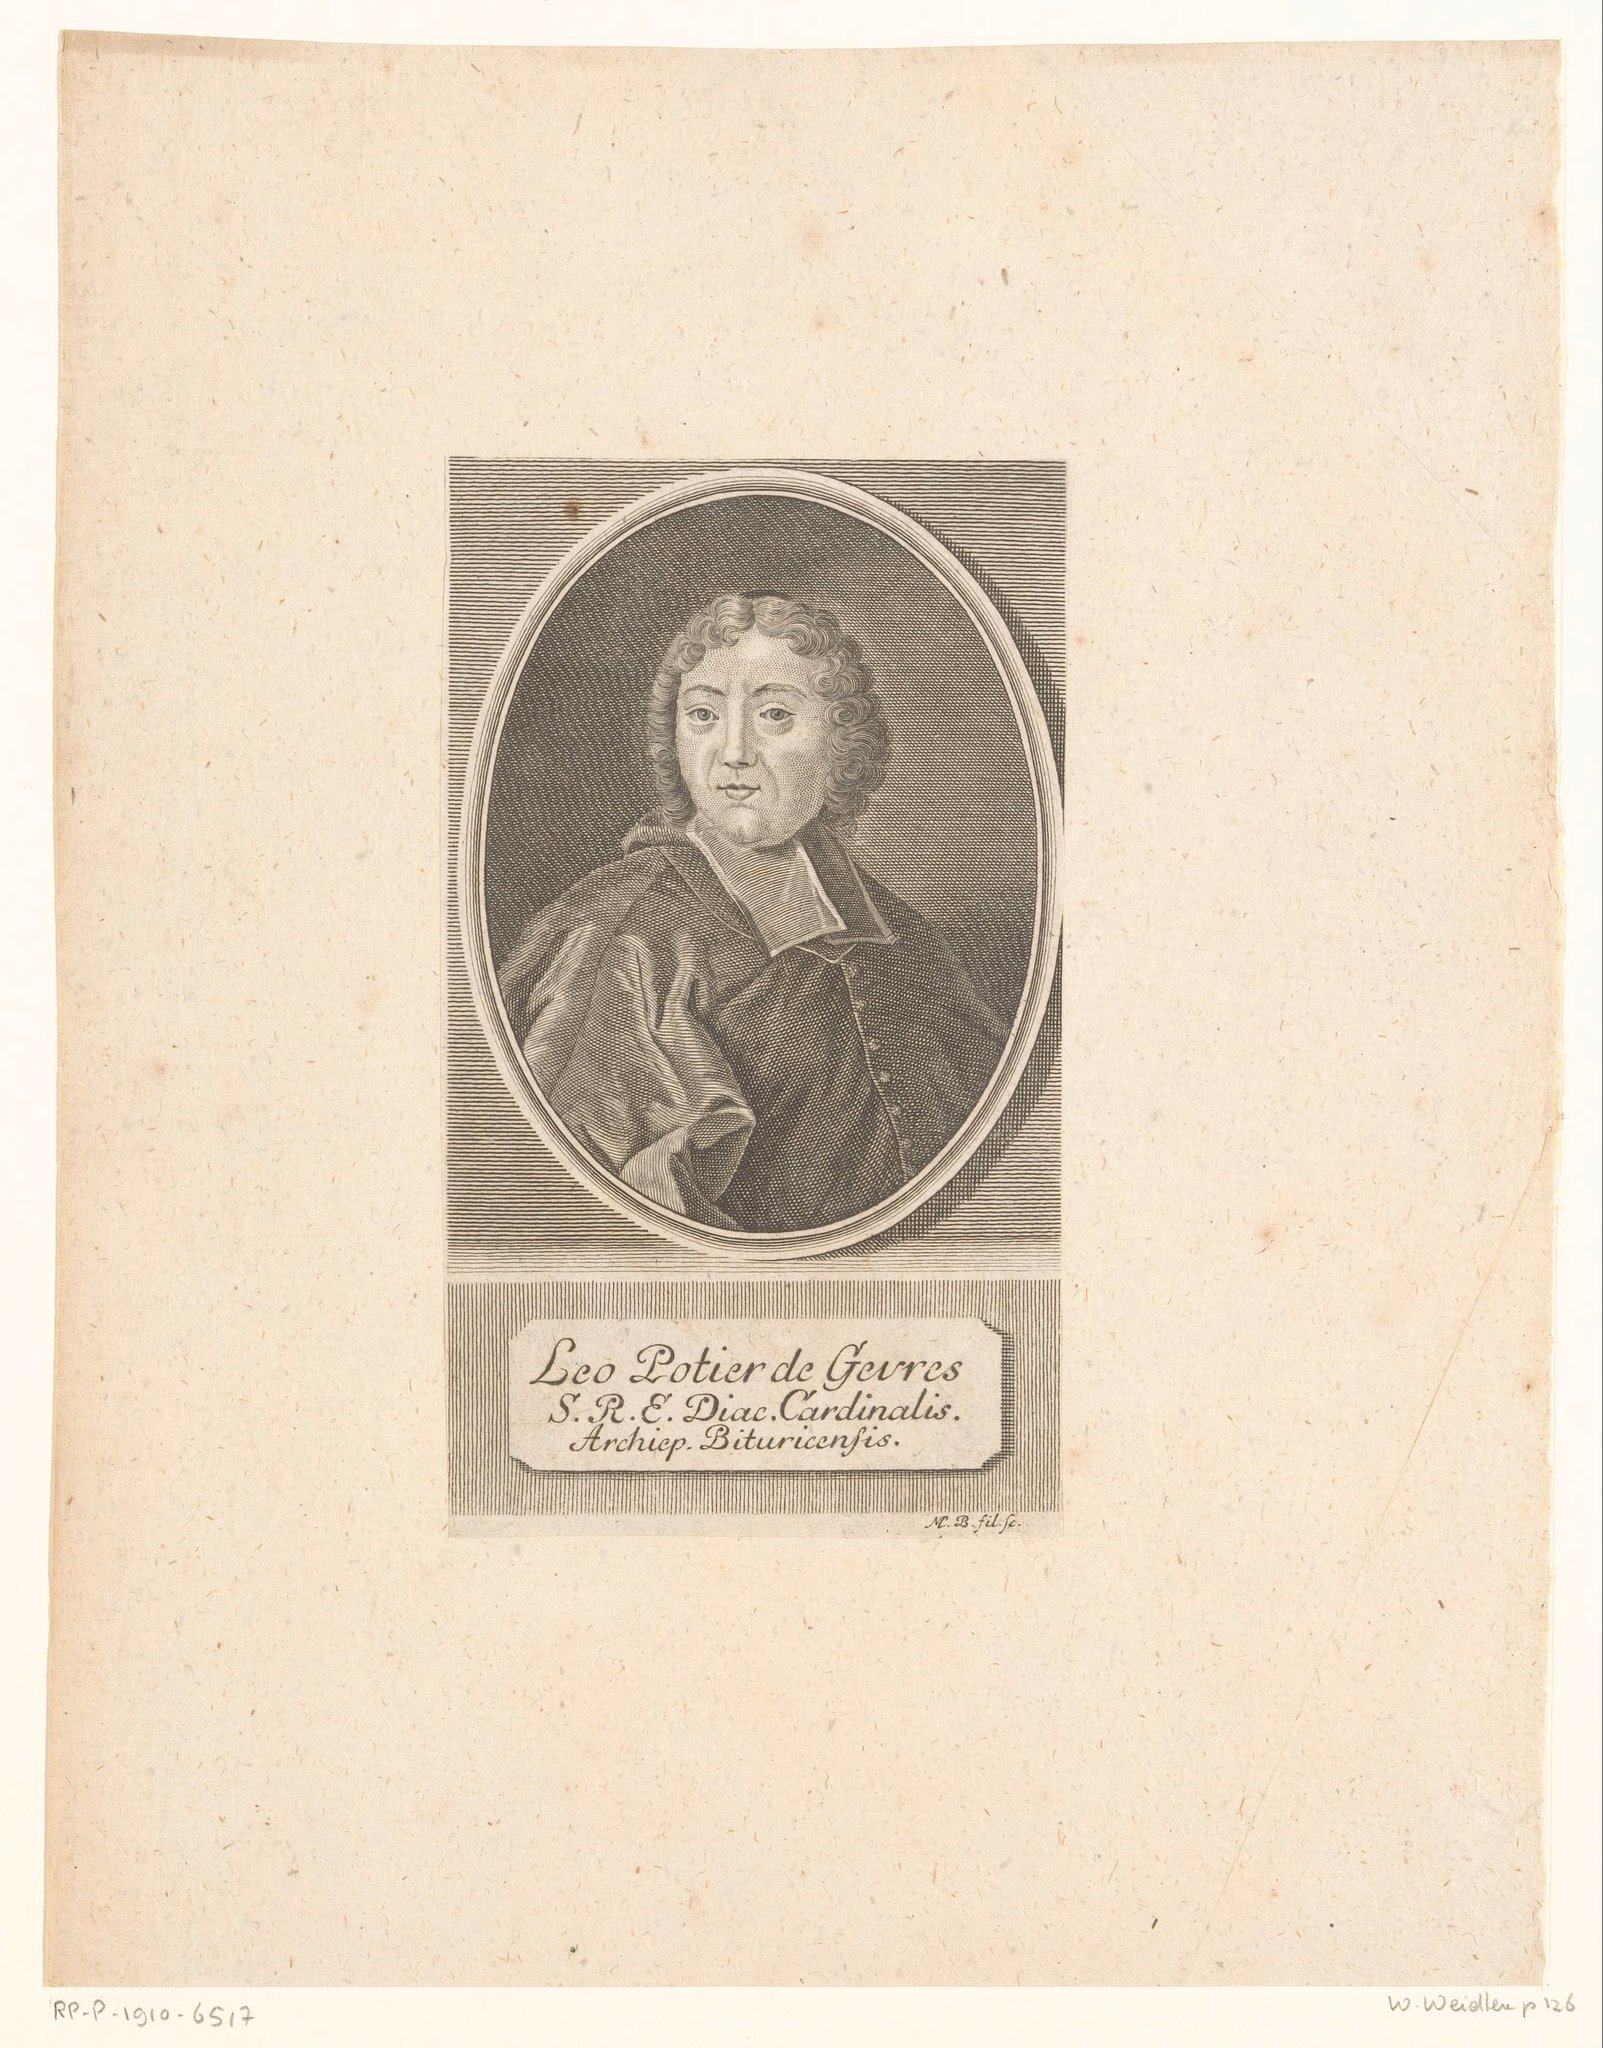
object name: print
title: Portret van Léon Potier de Gevres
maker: johann martin bernigeroth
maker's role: print maker, publisher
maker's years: 1713-1767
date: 1737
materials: paper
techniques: engraving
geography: leipzig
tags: paris, historical persons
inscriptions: collector's mark: Lugt 2228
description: Prent ook gebruikt in: Die Neue Europäische Fama, Welche den gegenwärtigen Zustand der vornehmsten Höfe entdecket. dl. 28. Leipzig: Gleditsch, 1737.